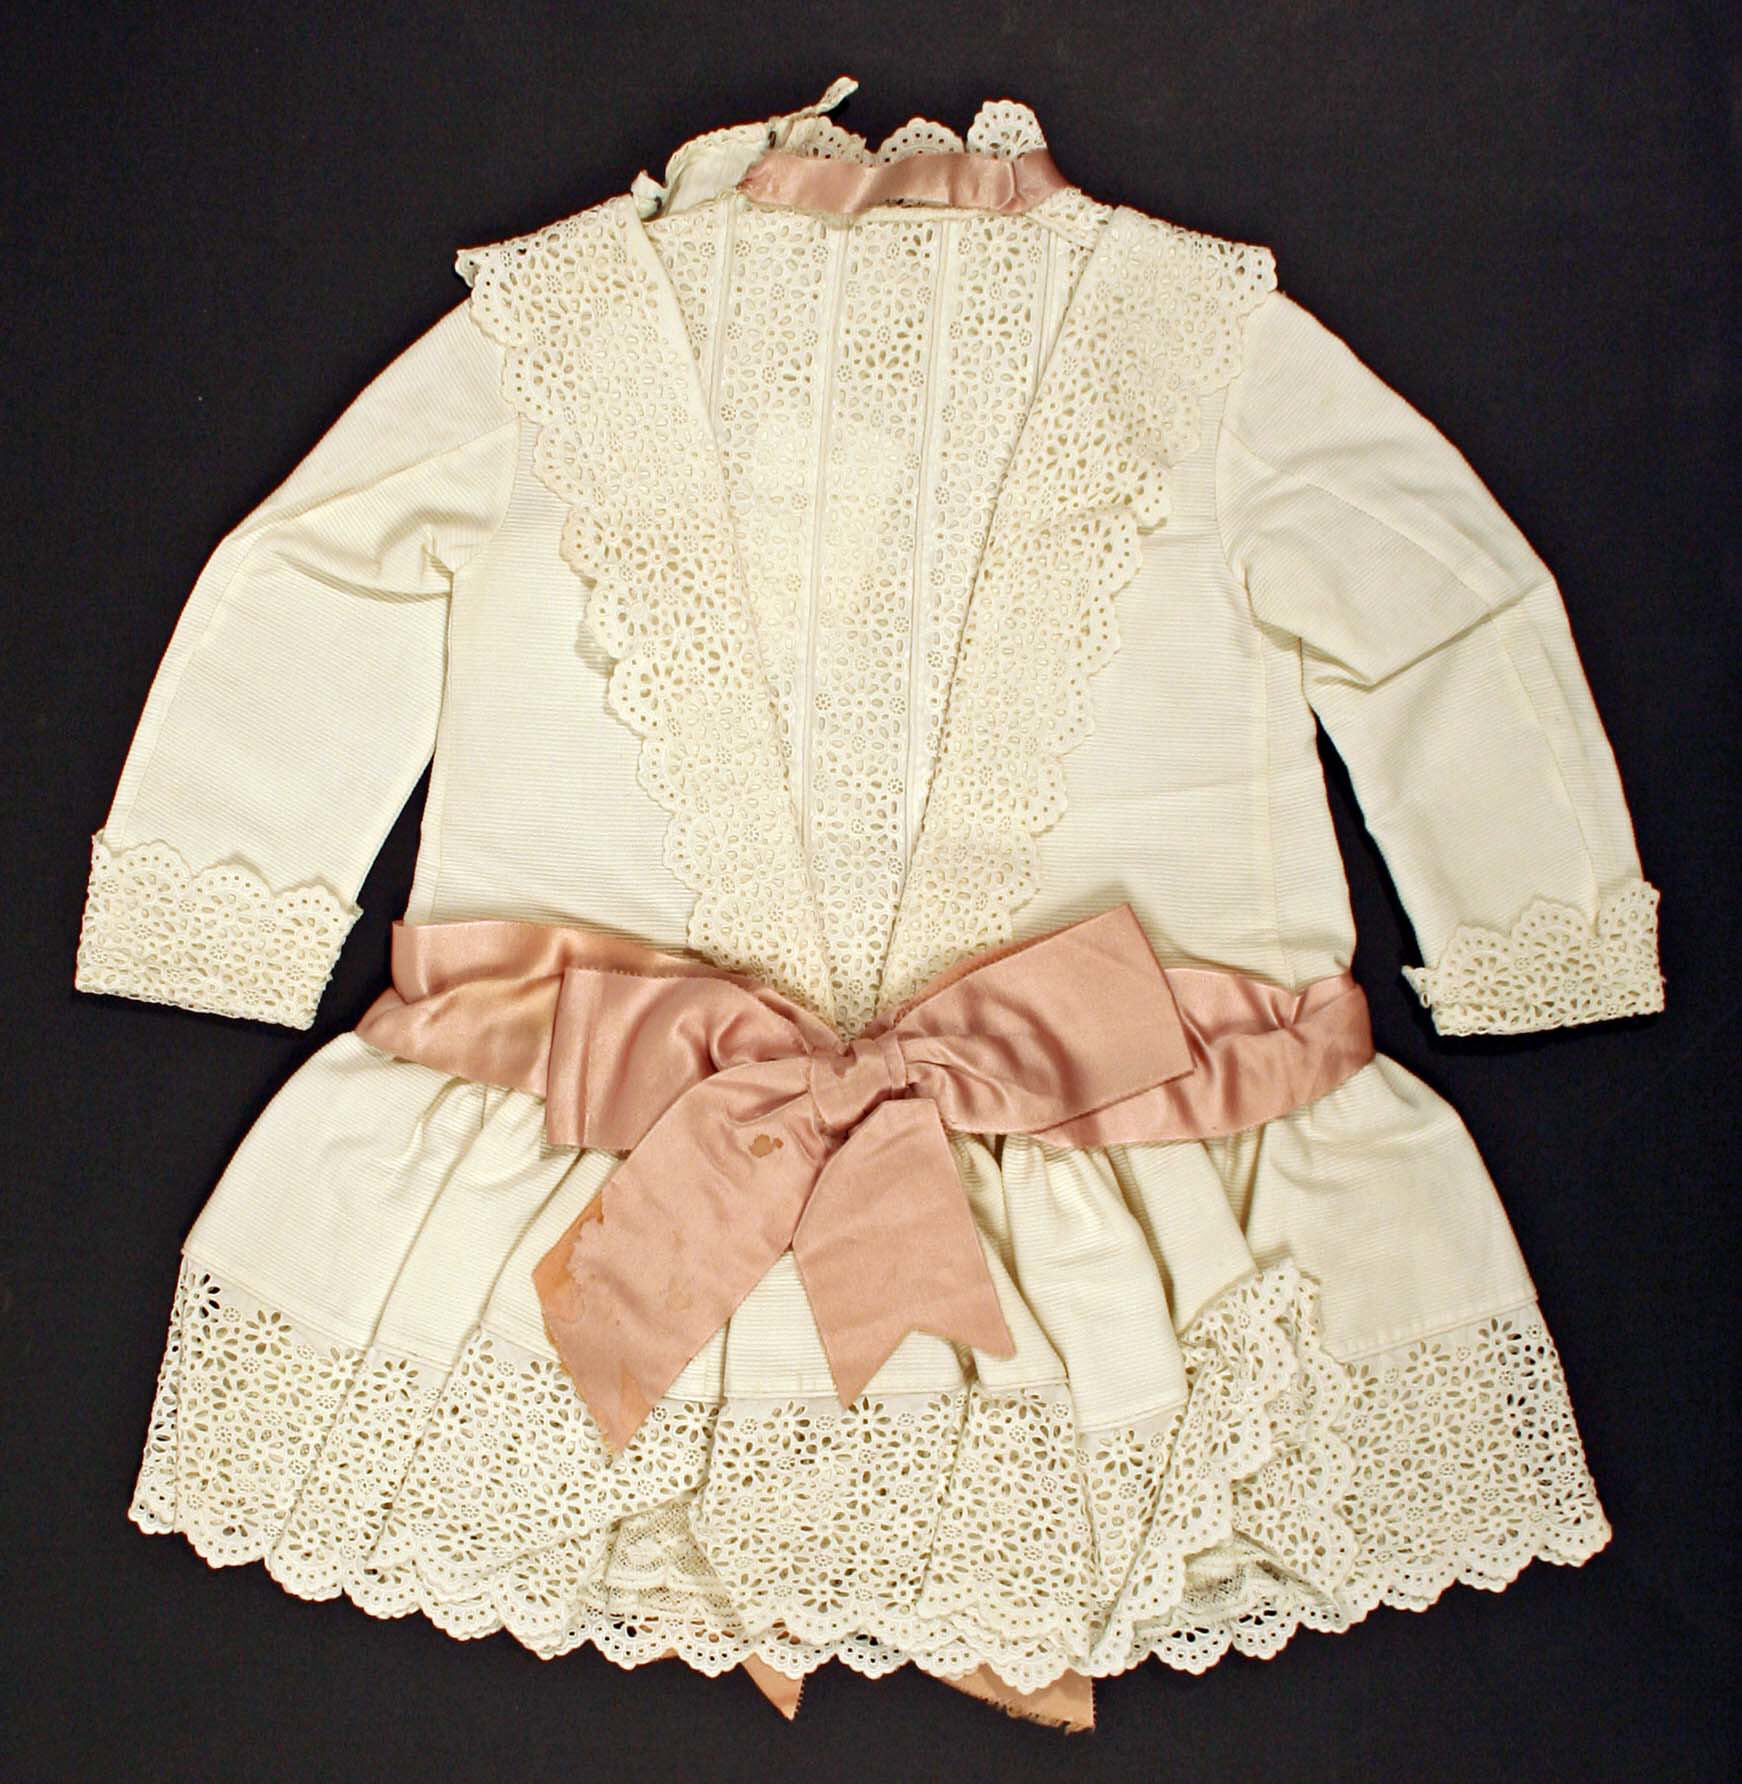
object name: dress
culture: american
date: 1890-1899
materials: cotton, silk